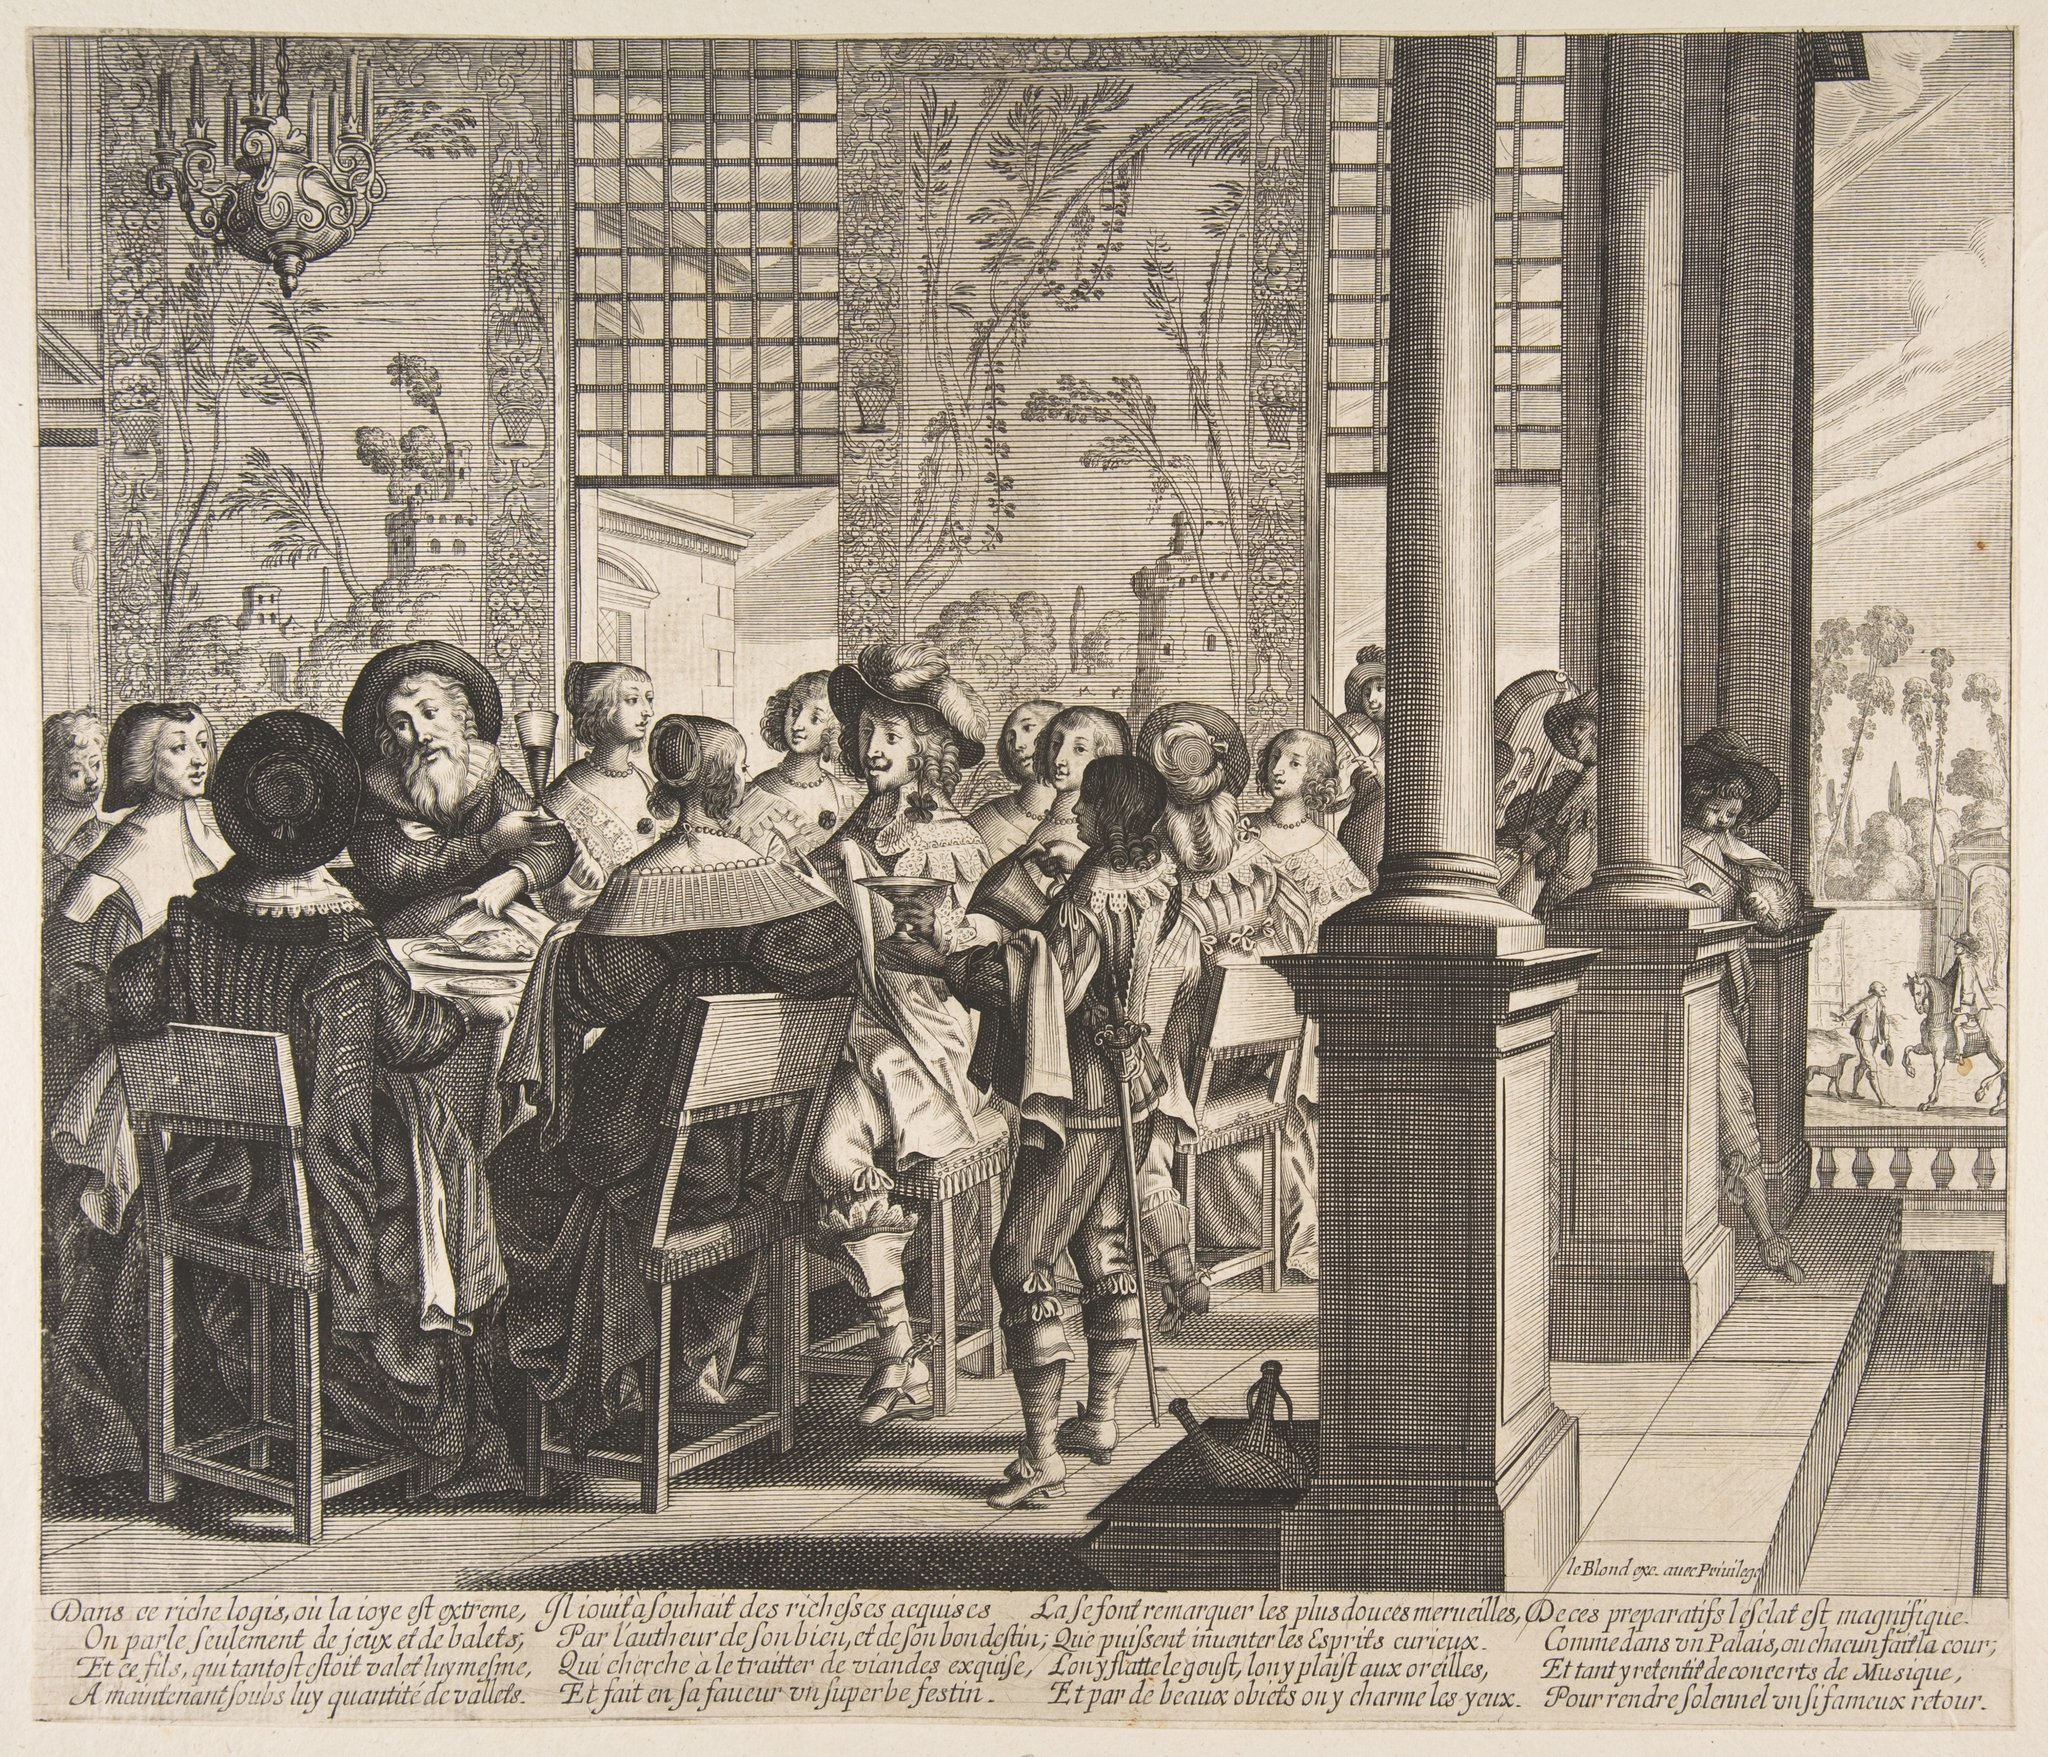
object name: print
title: The Banquet for the Return of the Prodigal Son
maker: Anonymous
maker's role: artist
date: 1636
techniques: engraving, etching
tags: men,women,drinking